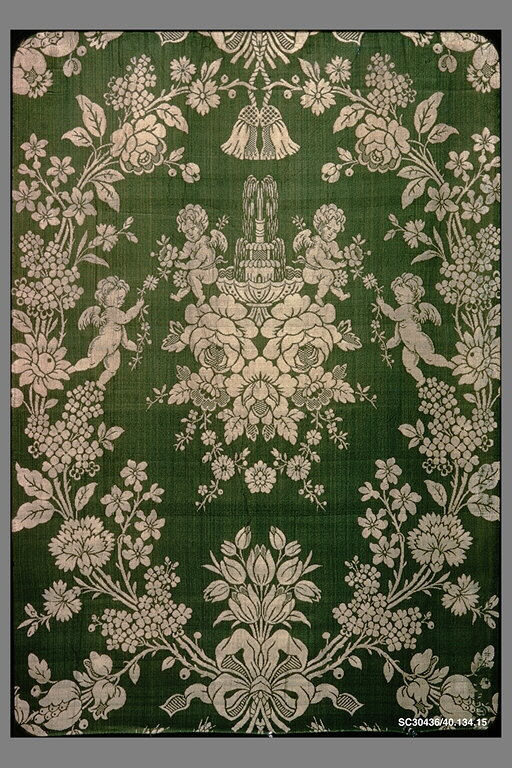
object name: piece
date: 1767-1800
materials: silk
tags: fountains,putti,flowers